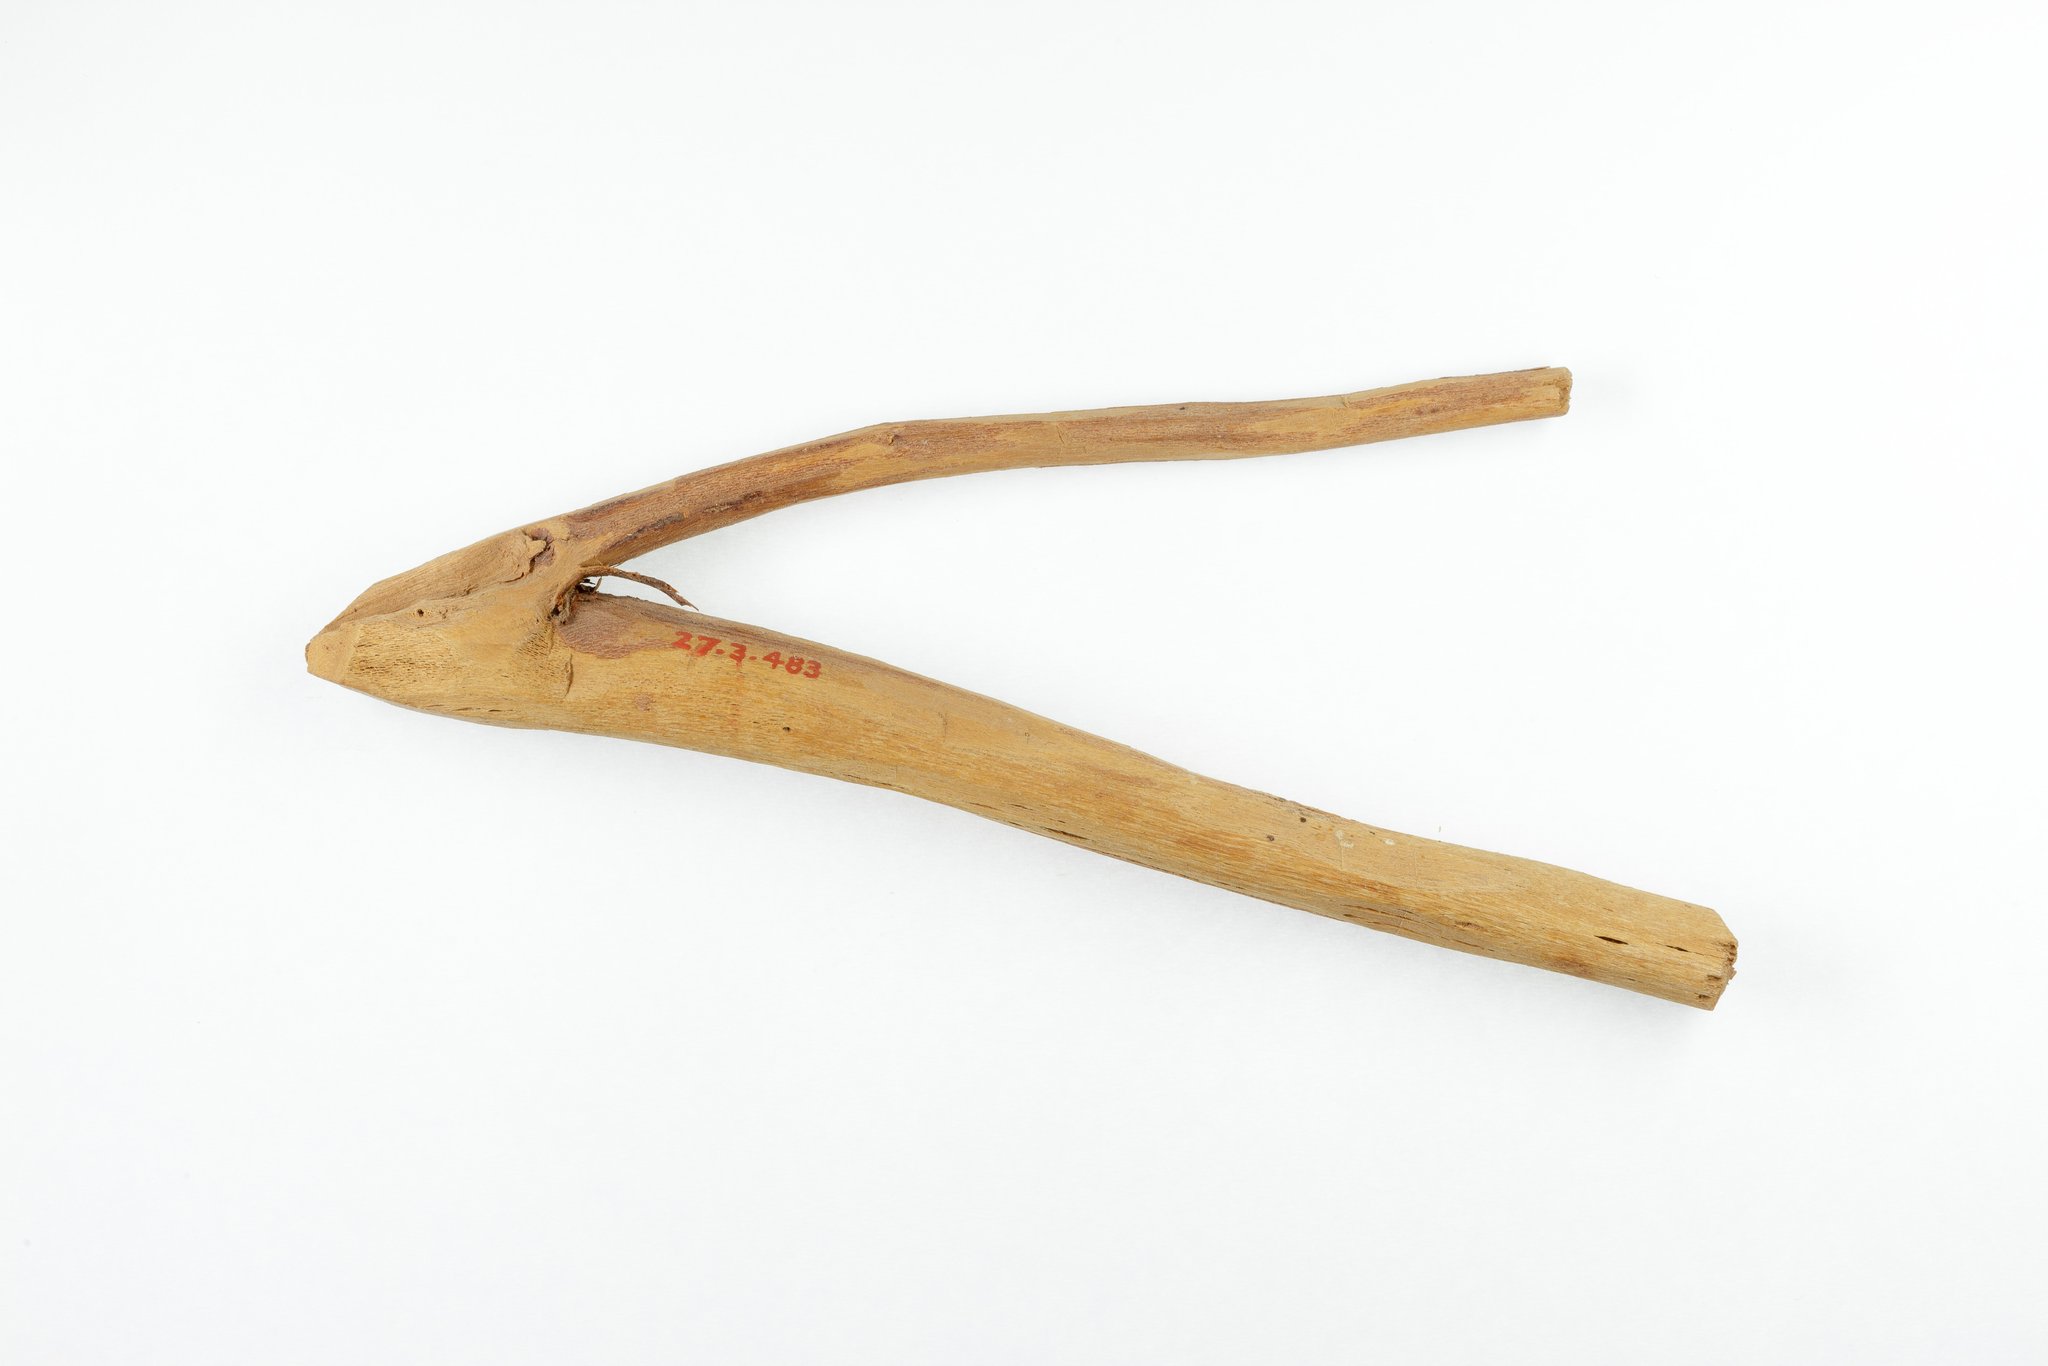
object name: pick, model, tool, senenmut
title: Model Pick from a Foundation Deposit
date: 1479-1458 BCE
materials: wood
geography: egypt